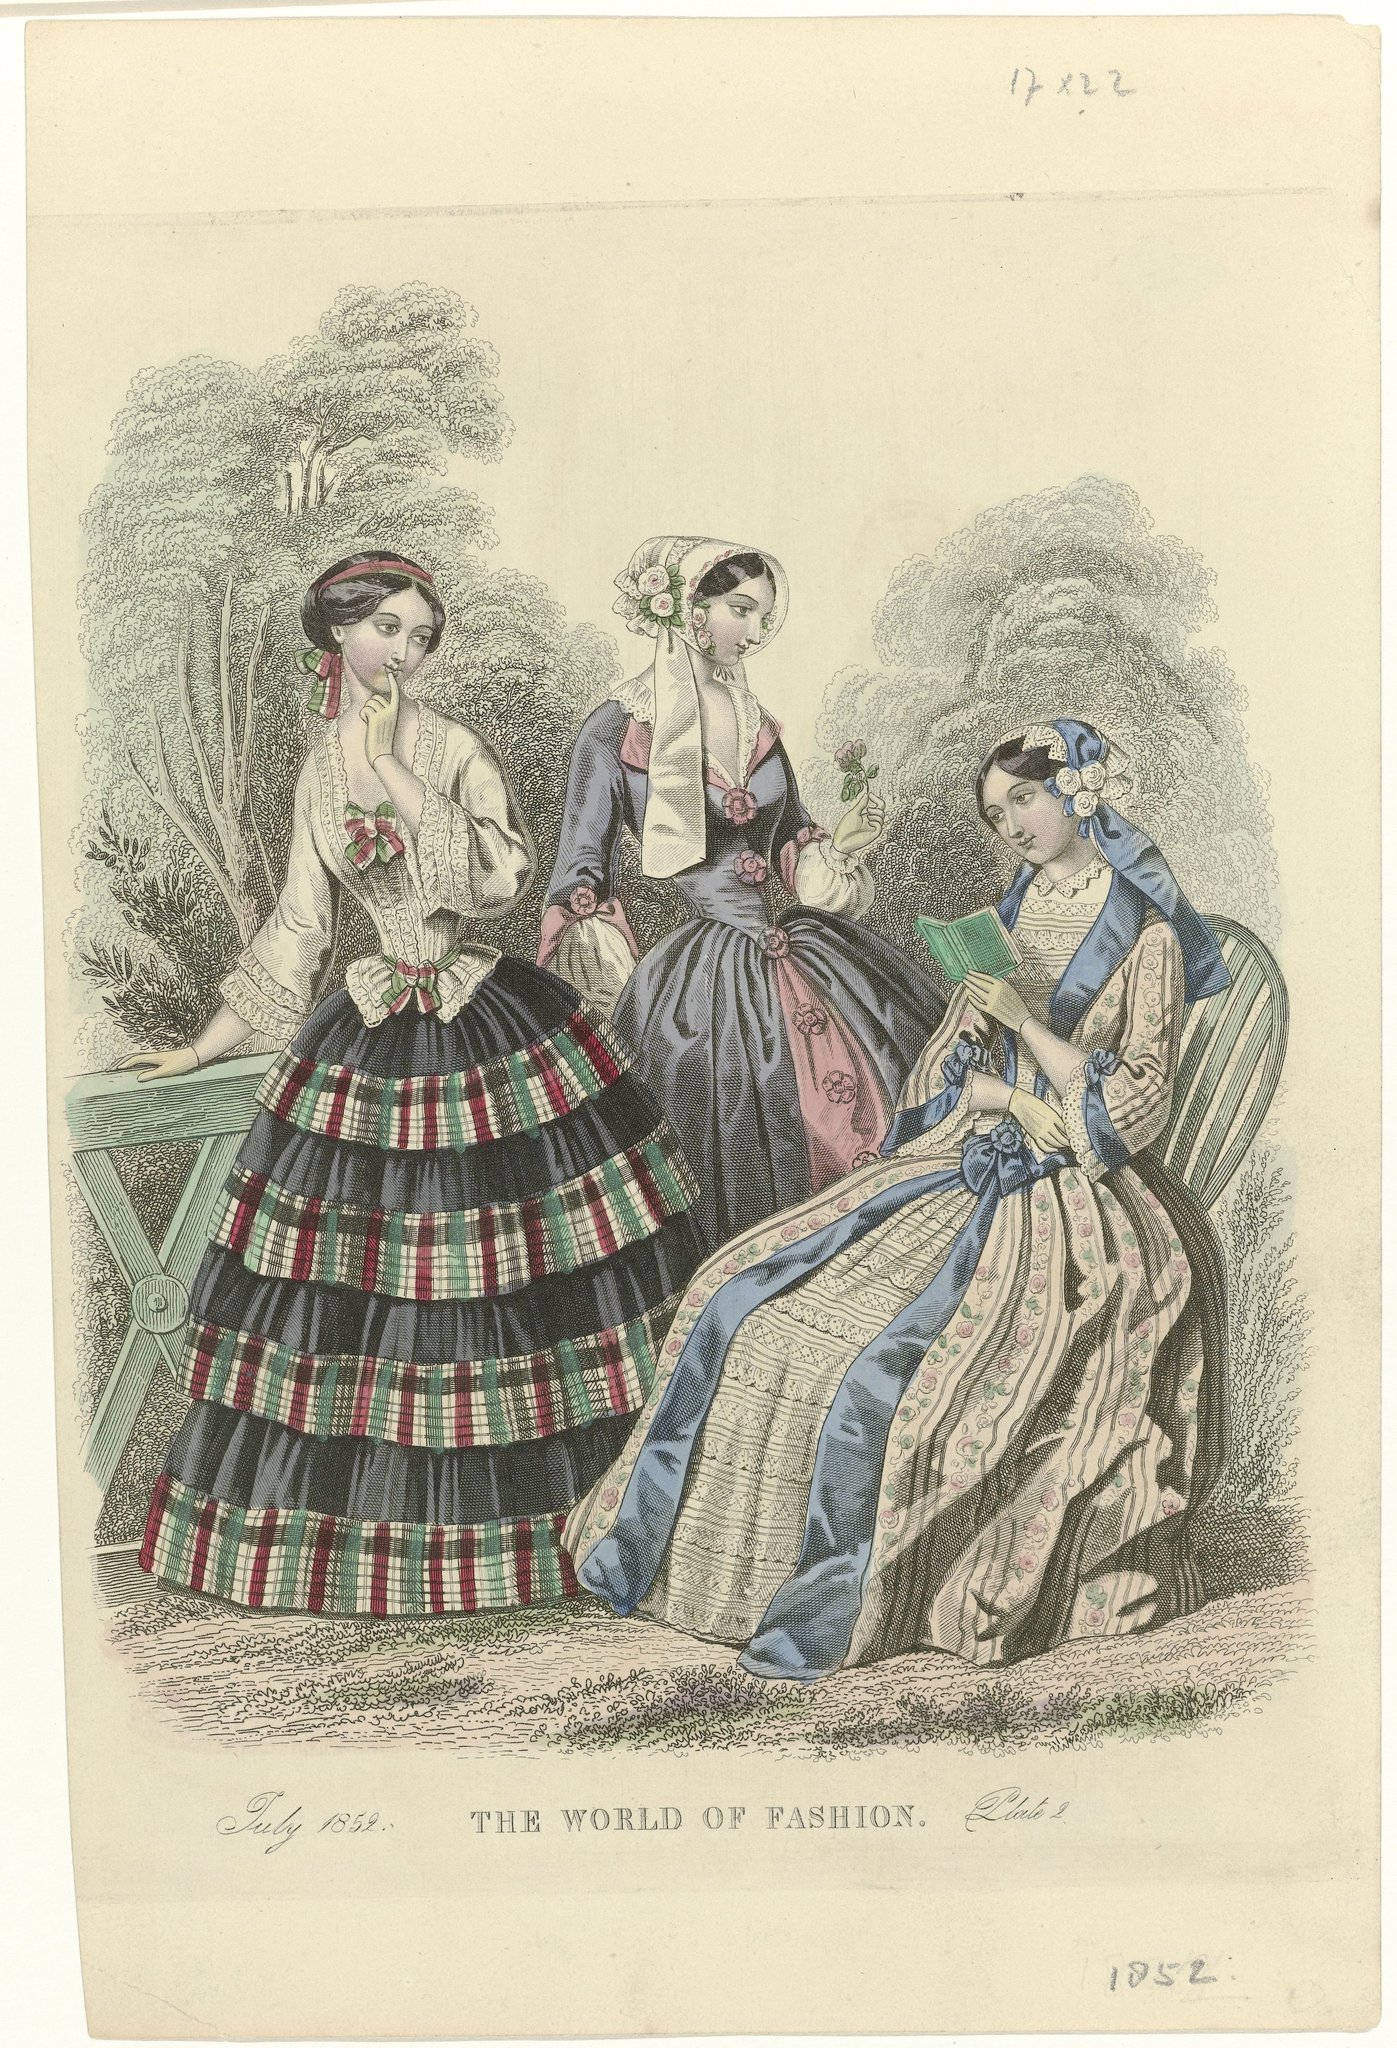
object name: fashion print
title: The World of Fashion, July 1852, Plate 2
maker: Anonymous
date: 1852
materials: paper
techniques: engraving, hand coloring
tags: bow (ornamental part of clothing) (+ women's clothes), clothing for the upper part of the body (+ women's clothes), cut flowers; nosegay, bunch of flowers, head-gear: cap (+ women's clothes), fashion plates, head-gear: hat (+ women's clothes), skirt (+ women's clothes), gloves, mittens, etc. (+ women's clothes), book - mm - book open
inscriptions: title: ‘July 1852. The World of Fashion. Plate 2’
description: Drie vrouwen, van links naar rechts: blouse op een wijde rok met geruite stroken. Japon met middenvoor rozetten. Hoed met striklinten. Japon met bloempatroon, afgezet met contrasterende band. Prent uit het modetijdschrift The World of Fashion (1824-1891).